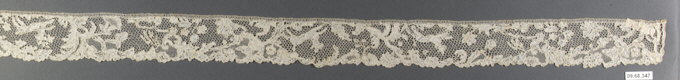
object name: strip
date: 1701-1800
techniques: lace